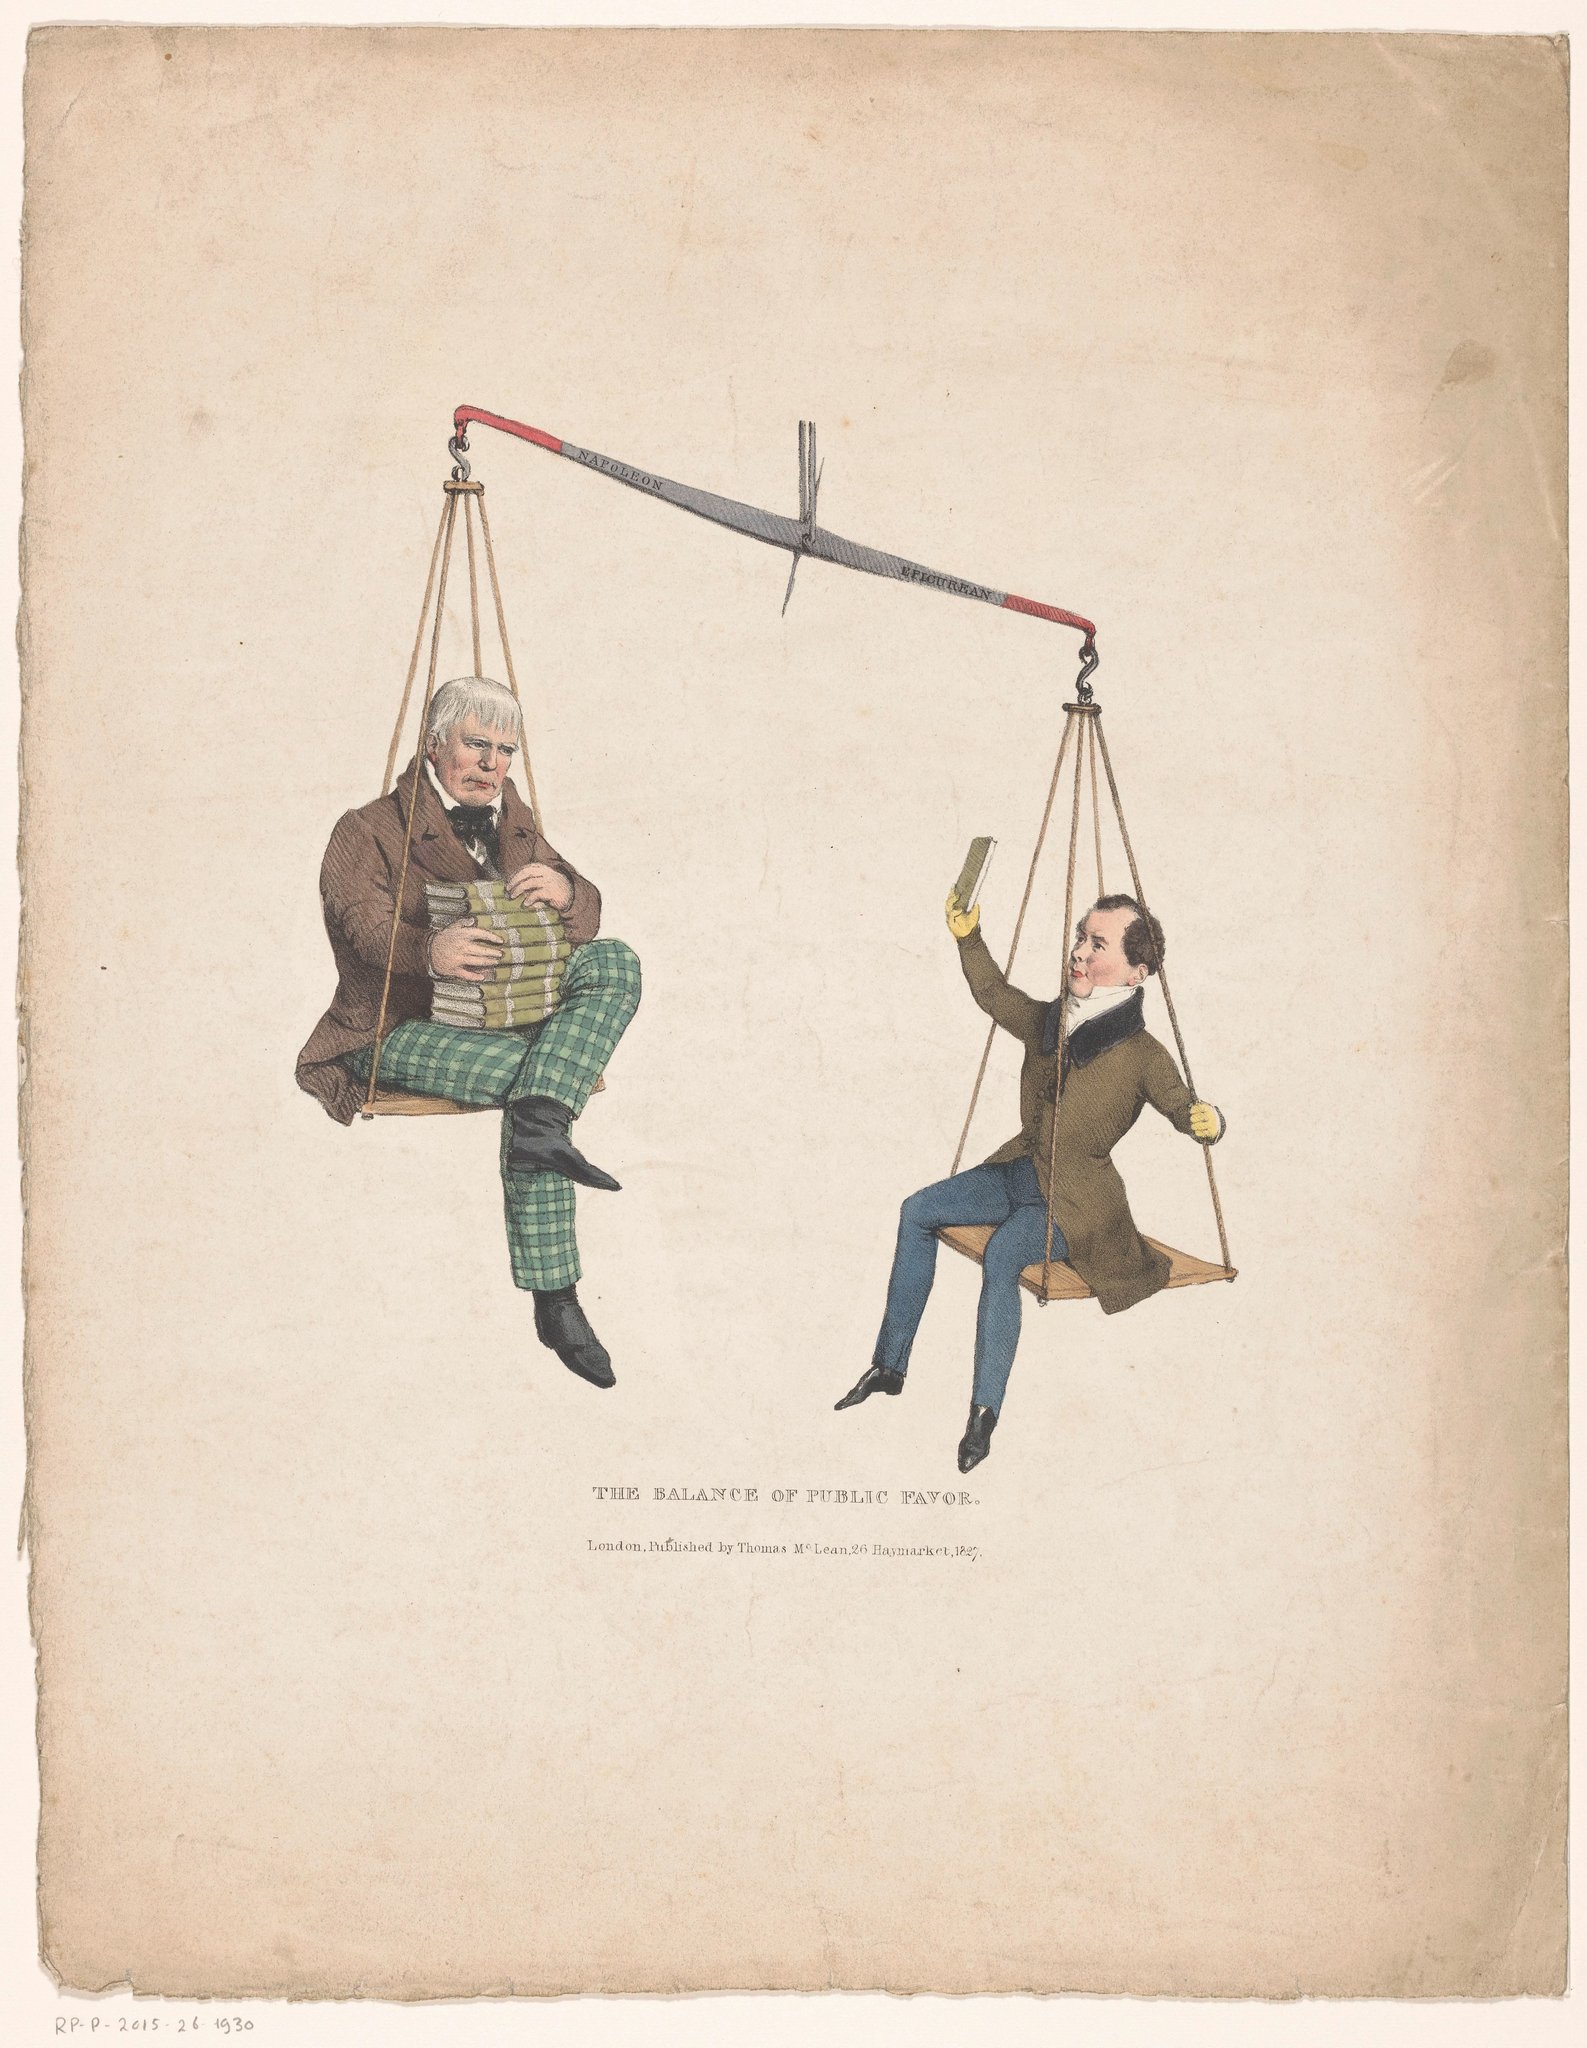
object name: print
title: Weegschaal met de schrijvers Walter Scott en Thomas Moore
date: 1827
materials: paper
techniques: hand coloring, lithograph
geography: london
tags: thomas moore, walter scott, scales, book, writer, poet, author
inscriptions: collector's mark: Lugt 2228, collector's mark: Lugt 4779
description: Een ongebalanceerde weegschaal met in de bovenste schaal Walter Scott met zijn negendelige werk over het leven van Napoleon Bonaparte en in de onderste schaal Thomas Moore die zijn boek 'The Epicurean' omhoog houdt.